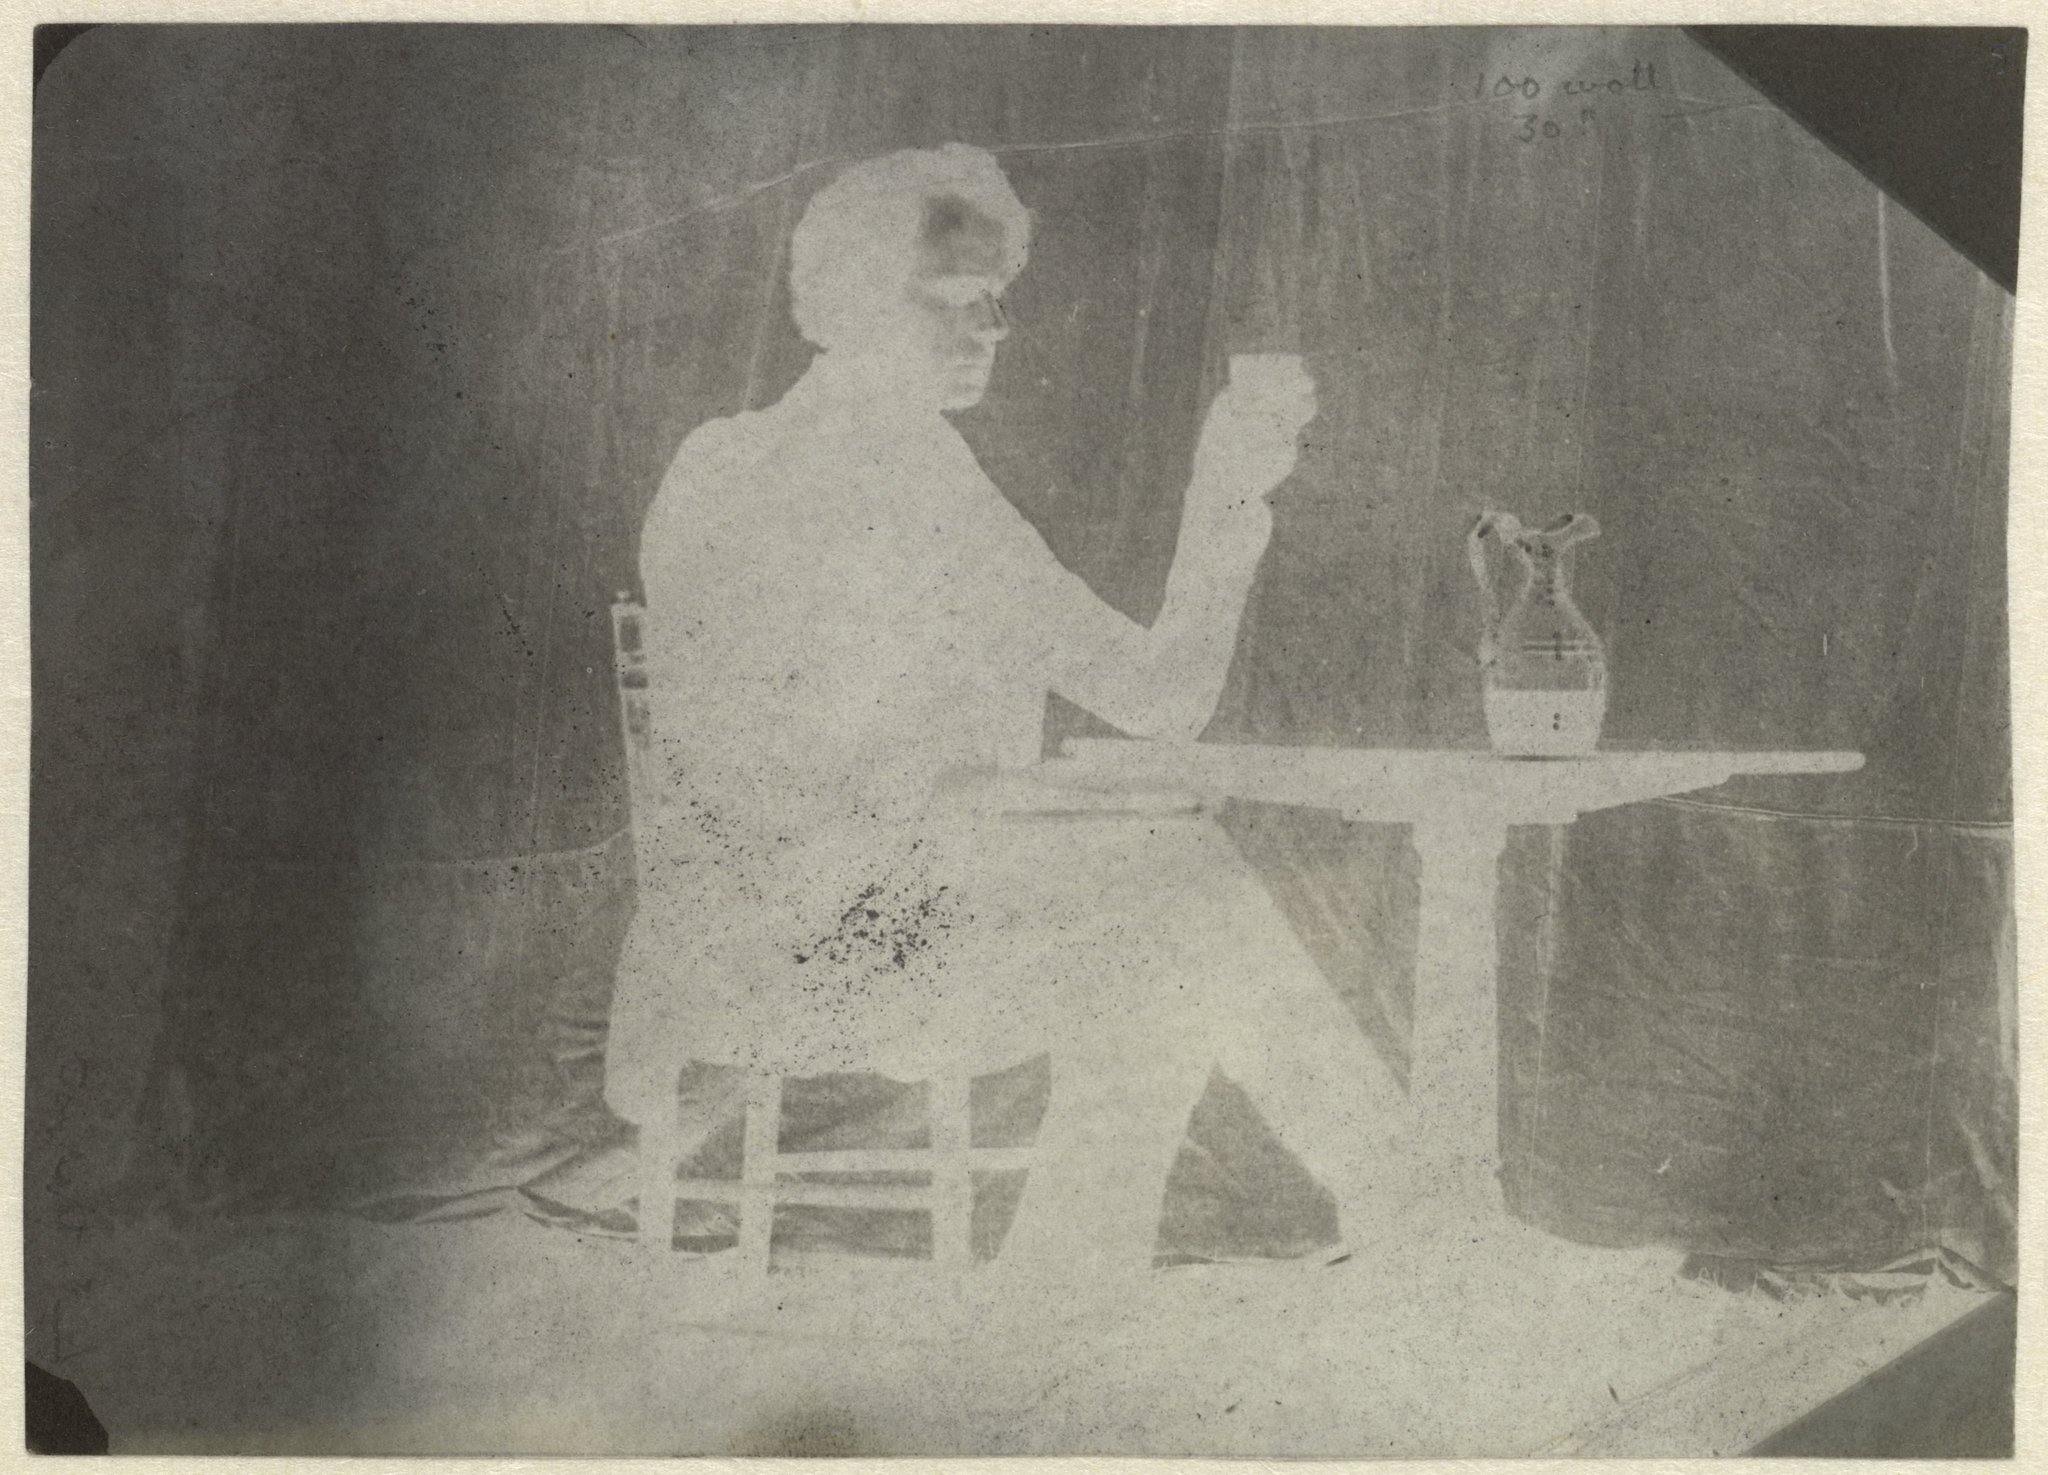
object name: papiernegatief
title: Portrait of Nicolaas Henneman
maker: william henry fox talbot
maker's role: fotograaf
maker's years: 1800-1877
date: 1842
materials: paper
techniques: paper negative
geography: england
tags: london, nicolaas henneman, adult man, historical persons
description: Talbot laid the foundation for photography’s golden future with his invention of the negative-positive process. It allowed the photographer to print a photog -raph multiple times. Talbot did not succeed in commercially exploiting his invention; in fact, his photo printing business failed. One of the persons whom he employed was a domestic originally from the Dutch province of Noord-Holland, Nicolaas Henneman. Talbot photographed his assistant in 1842.